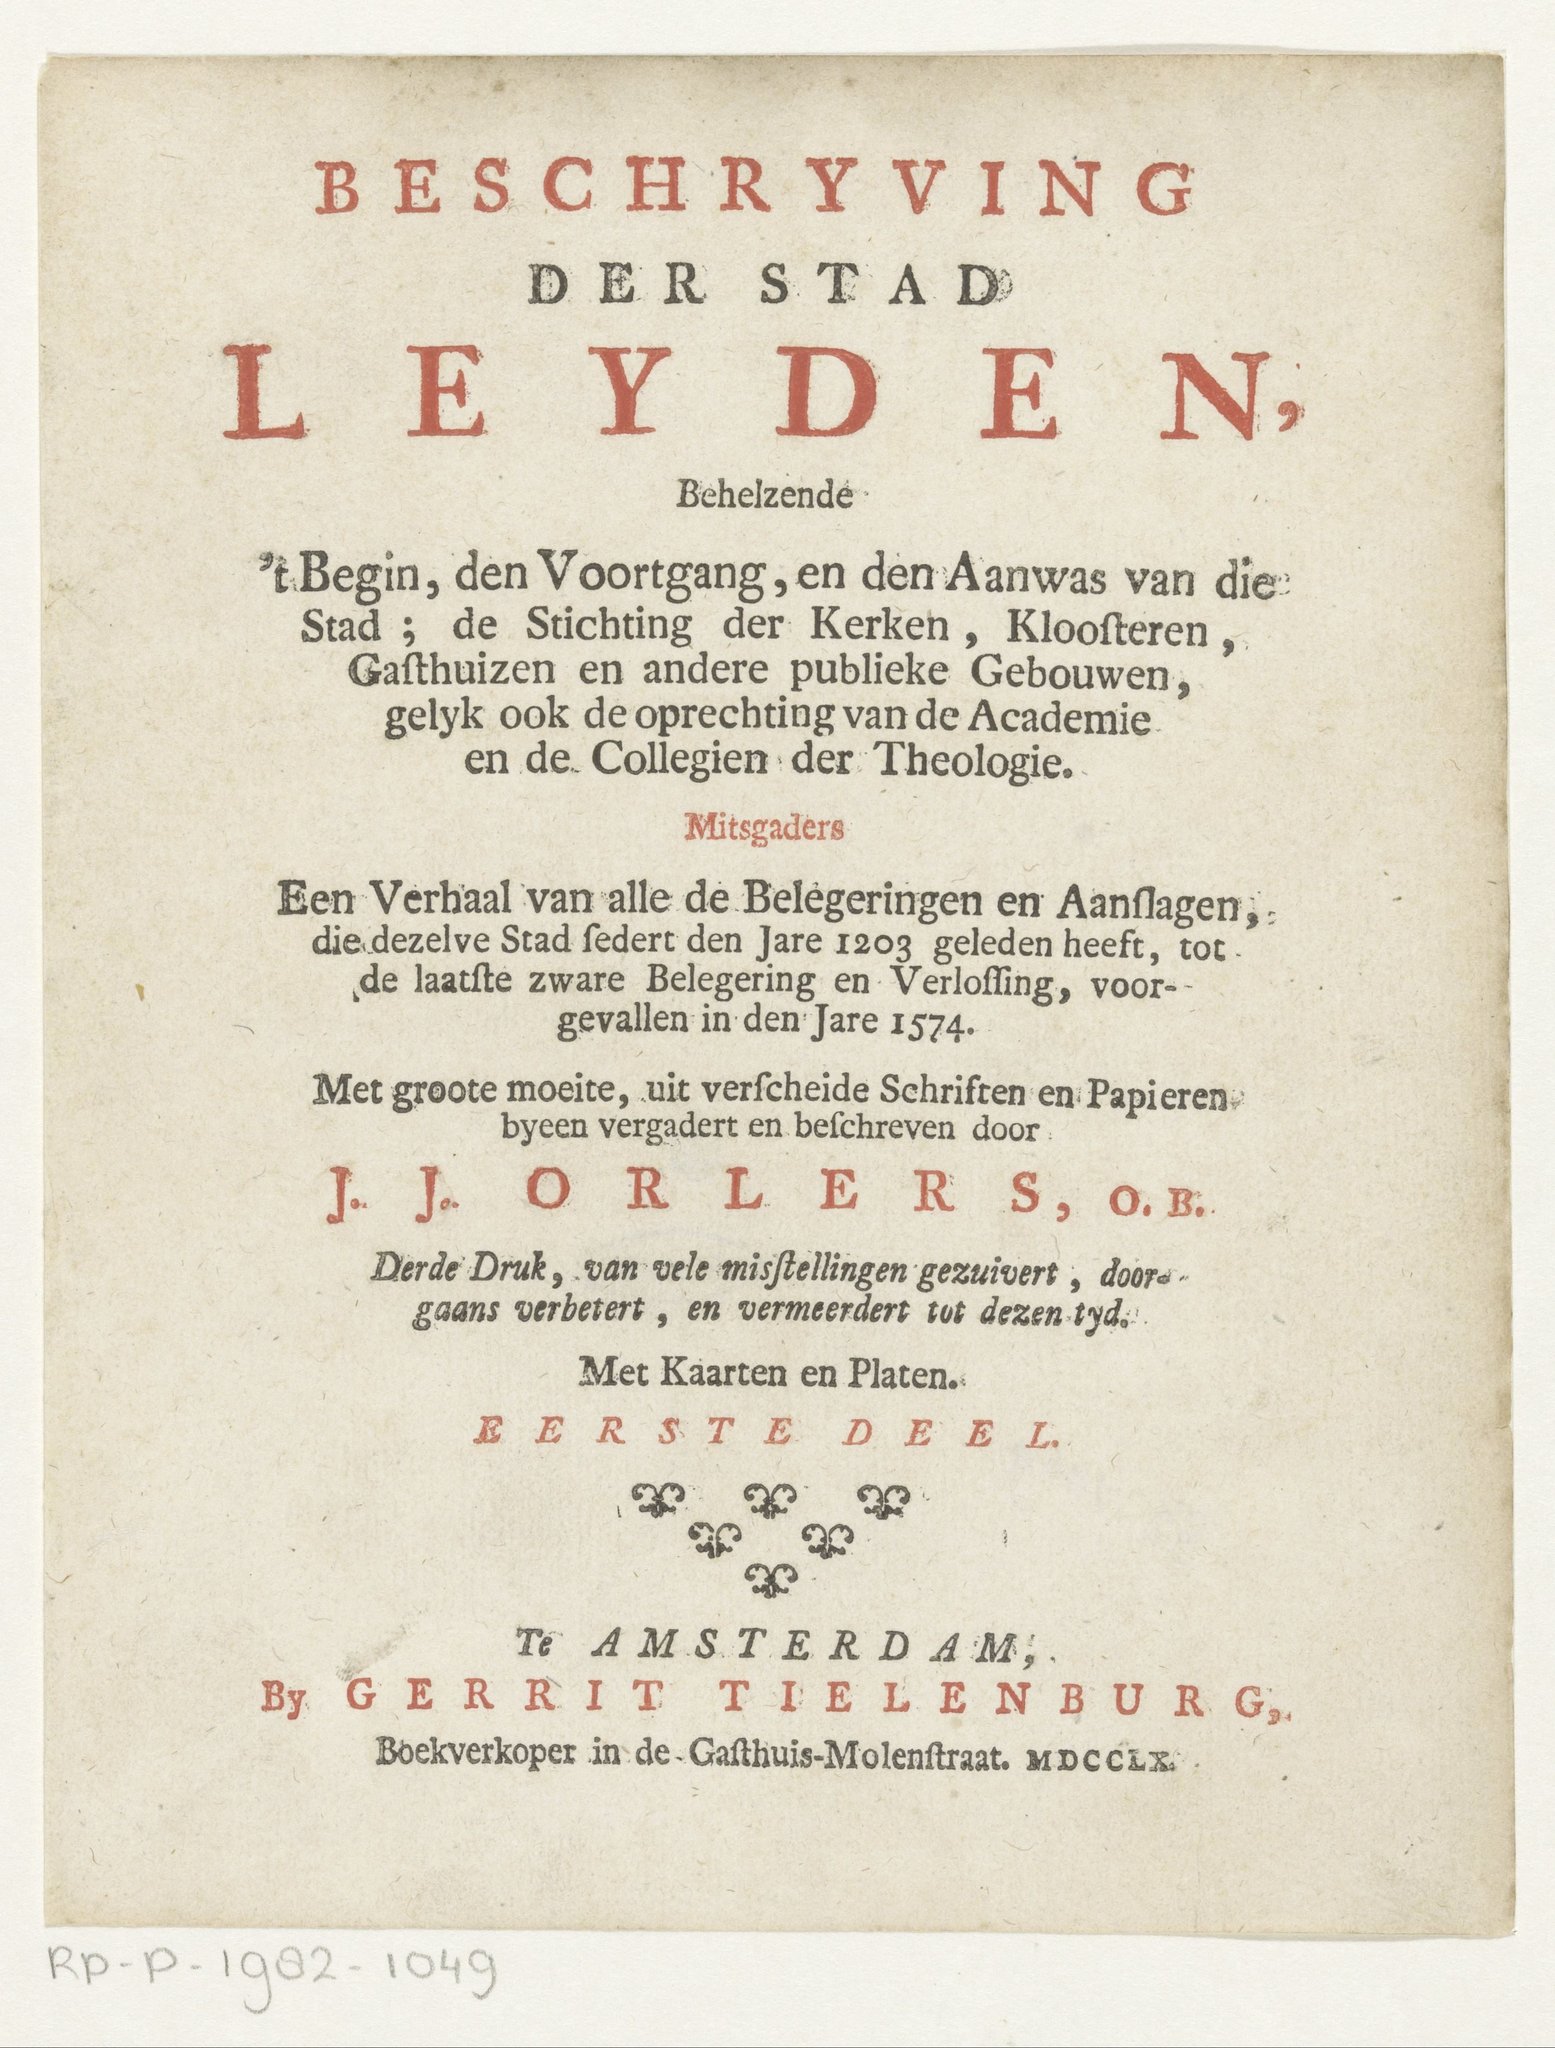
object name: titelblad, titelpagina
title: Titelpagina voor: Jan Jansz Orlers, Beschryving der stad Leyden. Eerste deel, 1760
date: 1760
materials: paper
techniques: letterpress printing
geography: amsterdam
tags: title-page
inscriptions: collector's mark: Lugt 2760, collector's mark: Lugt 2228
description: Titelpagina voor: Orlers, Jan Jansz. Beschryving der stad Leyden. Eerste deel. Amsterdam: Tielenburg, Gerrit, 1760.